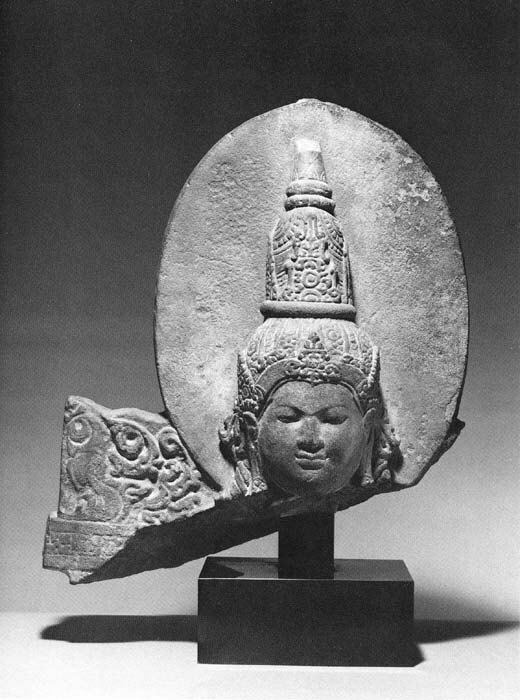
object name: head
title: Head of a Buddhist Deity, Perhaps Amitabha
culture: indonesian, kalimantan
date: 1101-1300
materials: stone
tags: heads,buddhism,deities